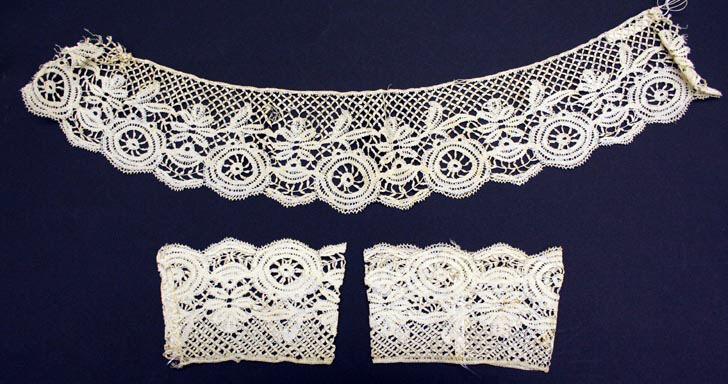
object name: accessory set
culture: american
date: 1700-1939